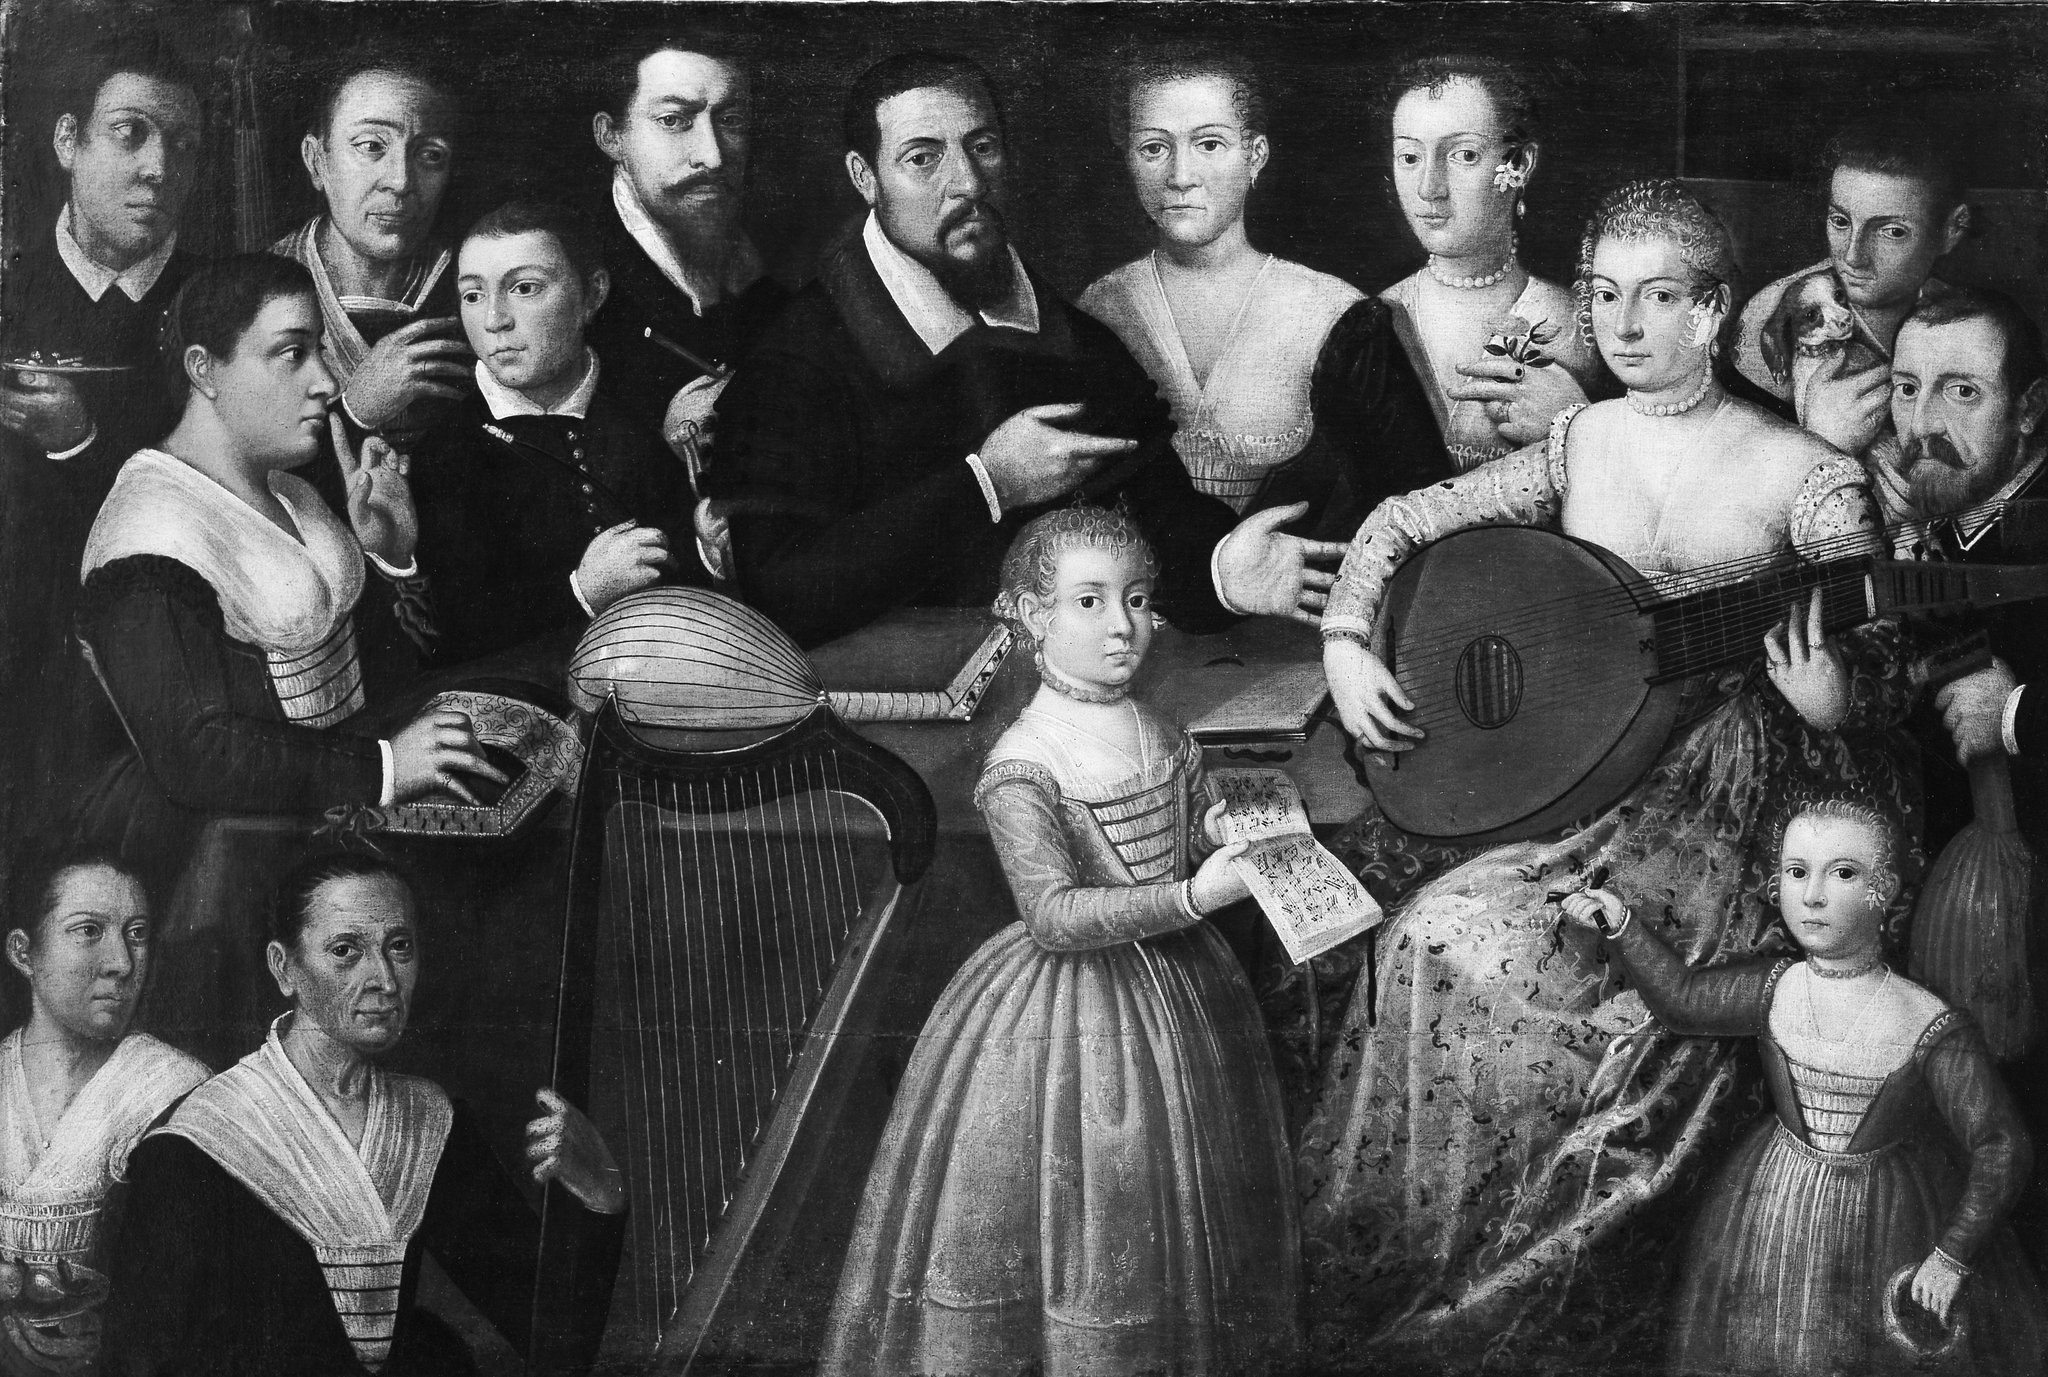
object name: portrait of a family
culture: italian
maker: girolamo forni and assistant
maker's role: maker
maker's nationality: italian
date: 1551-1600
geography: italy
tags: girls,men,portraits,women,harps,lutes